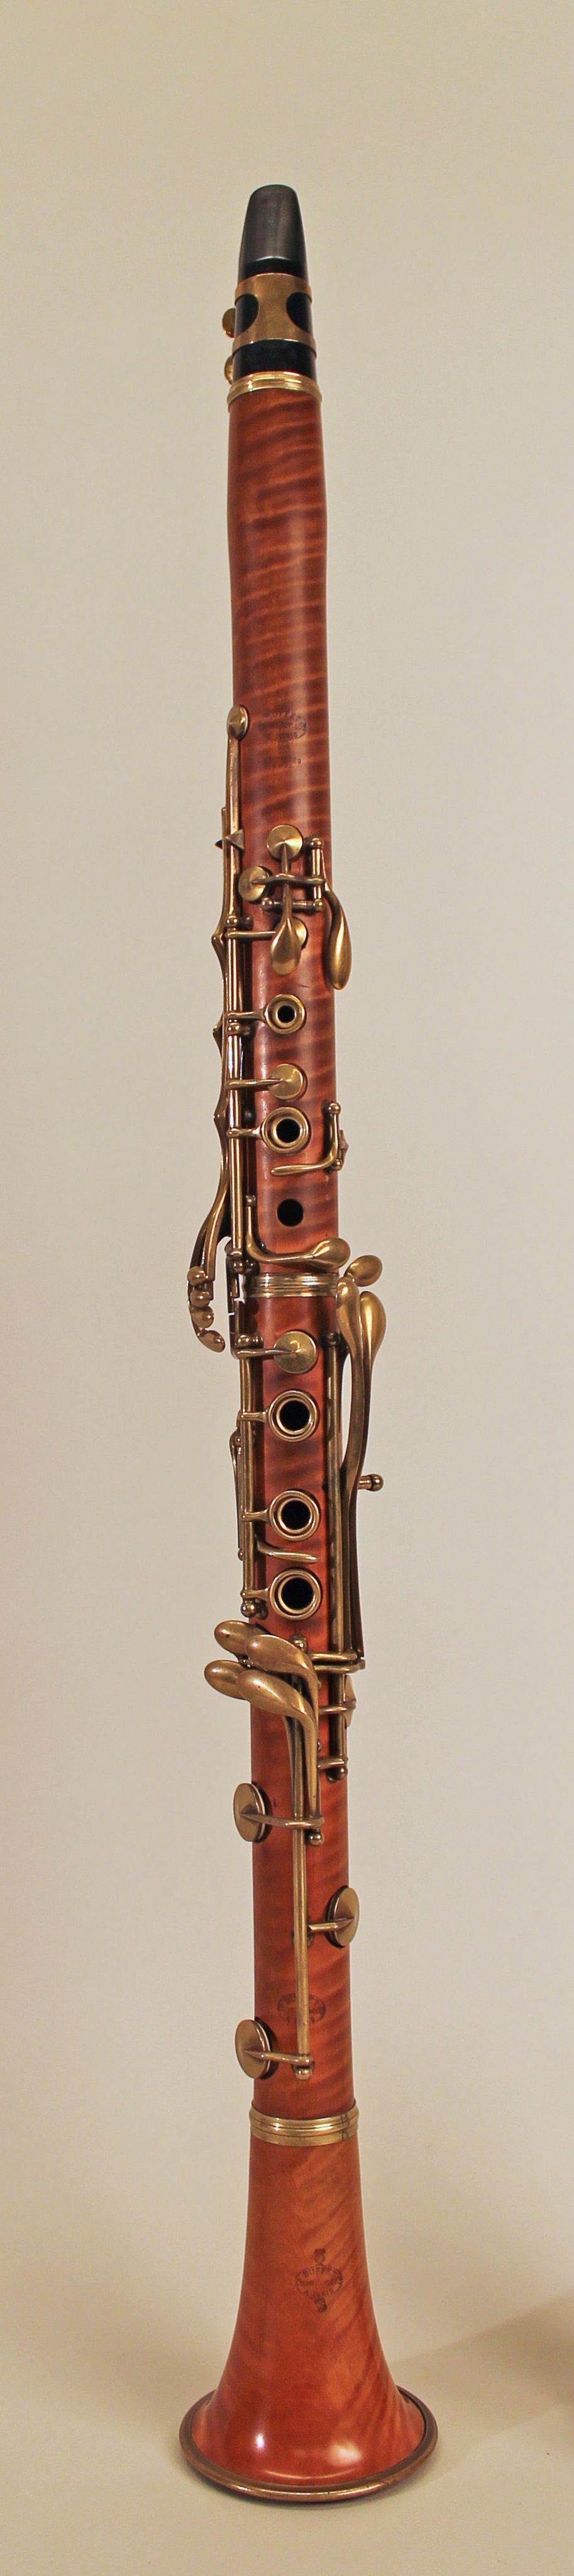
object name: clarinet in d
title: Clarinet in A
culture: french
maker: buffet, crampon & cie.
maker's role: maker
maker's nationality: french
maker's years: 1859-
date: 1860-1865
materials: wood, brass, gold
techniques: wash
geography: france